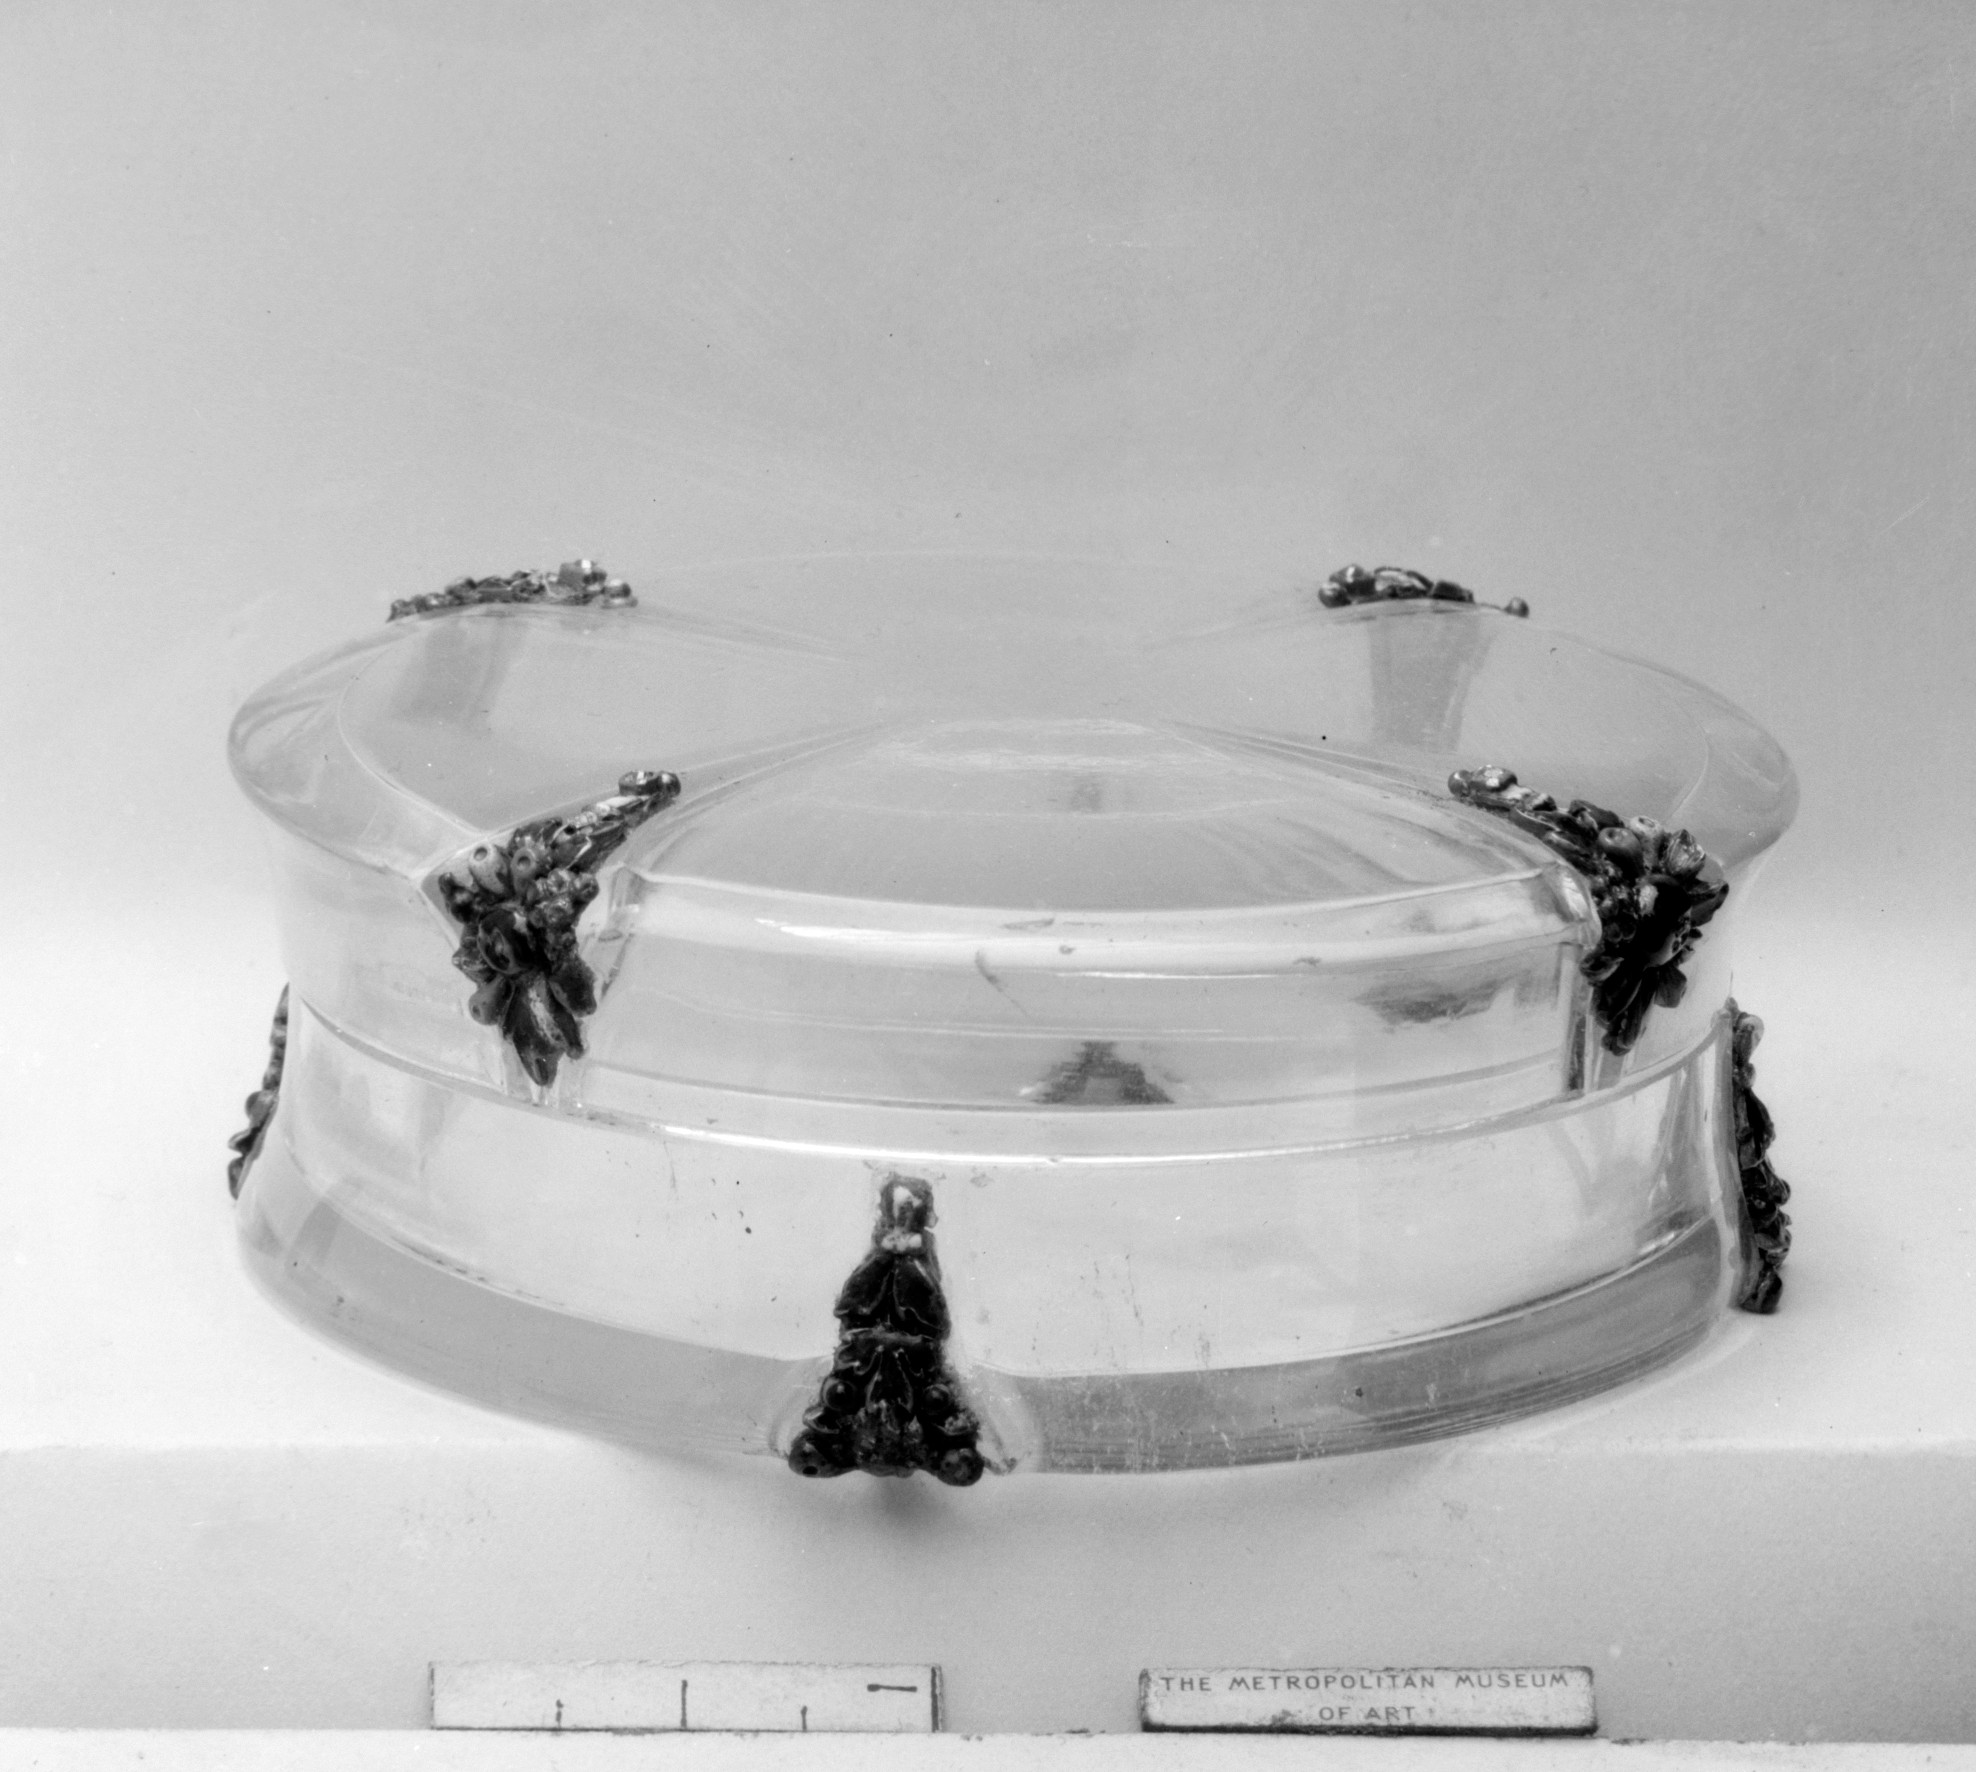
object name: box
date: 1767-1800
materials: diamond, enamel, glass, gold